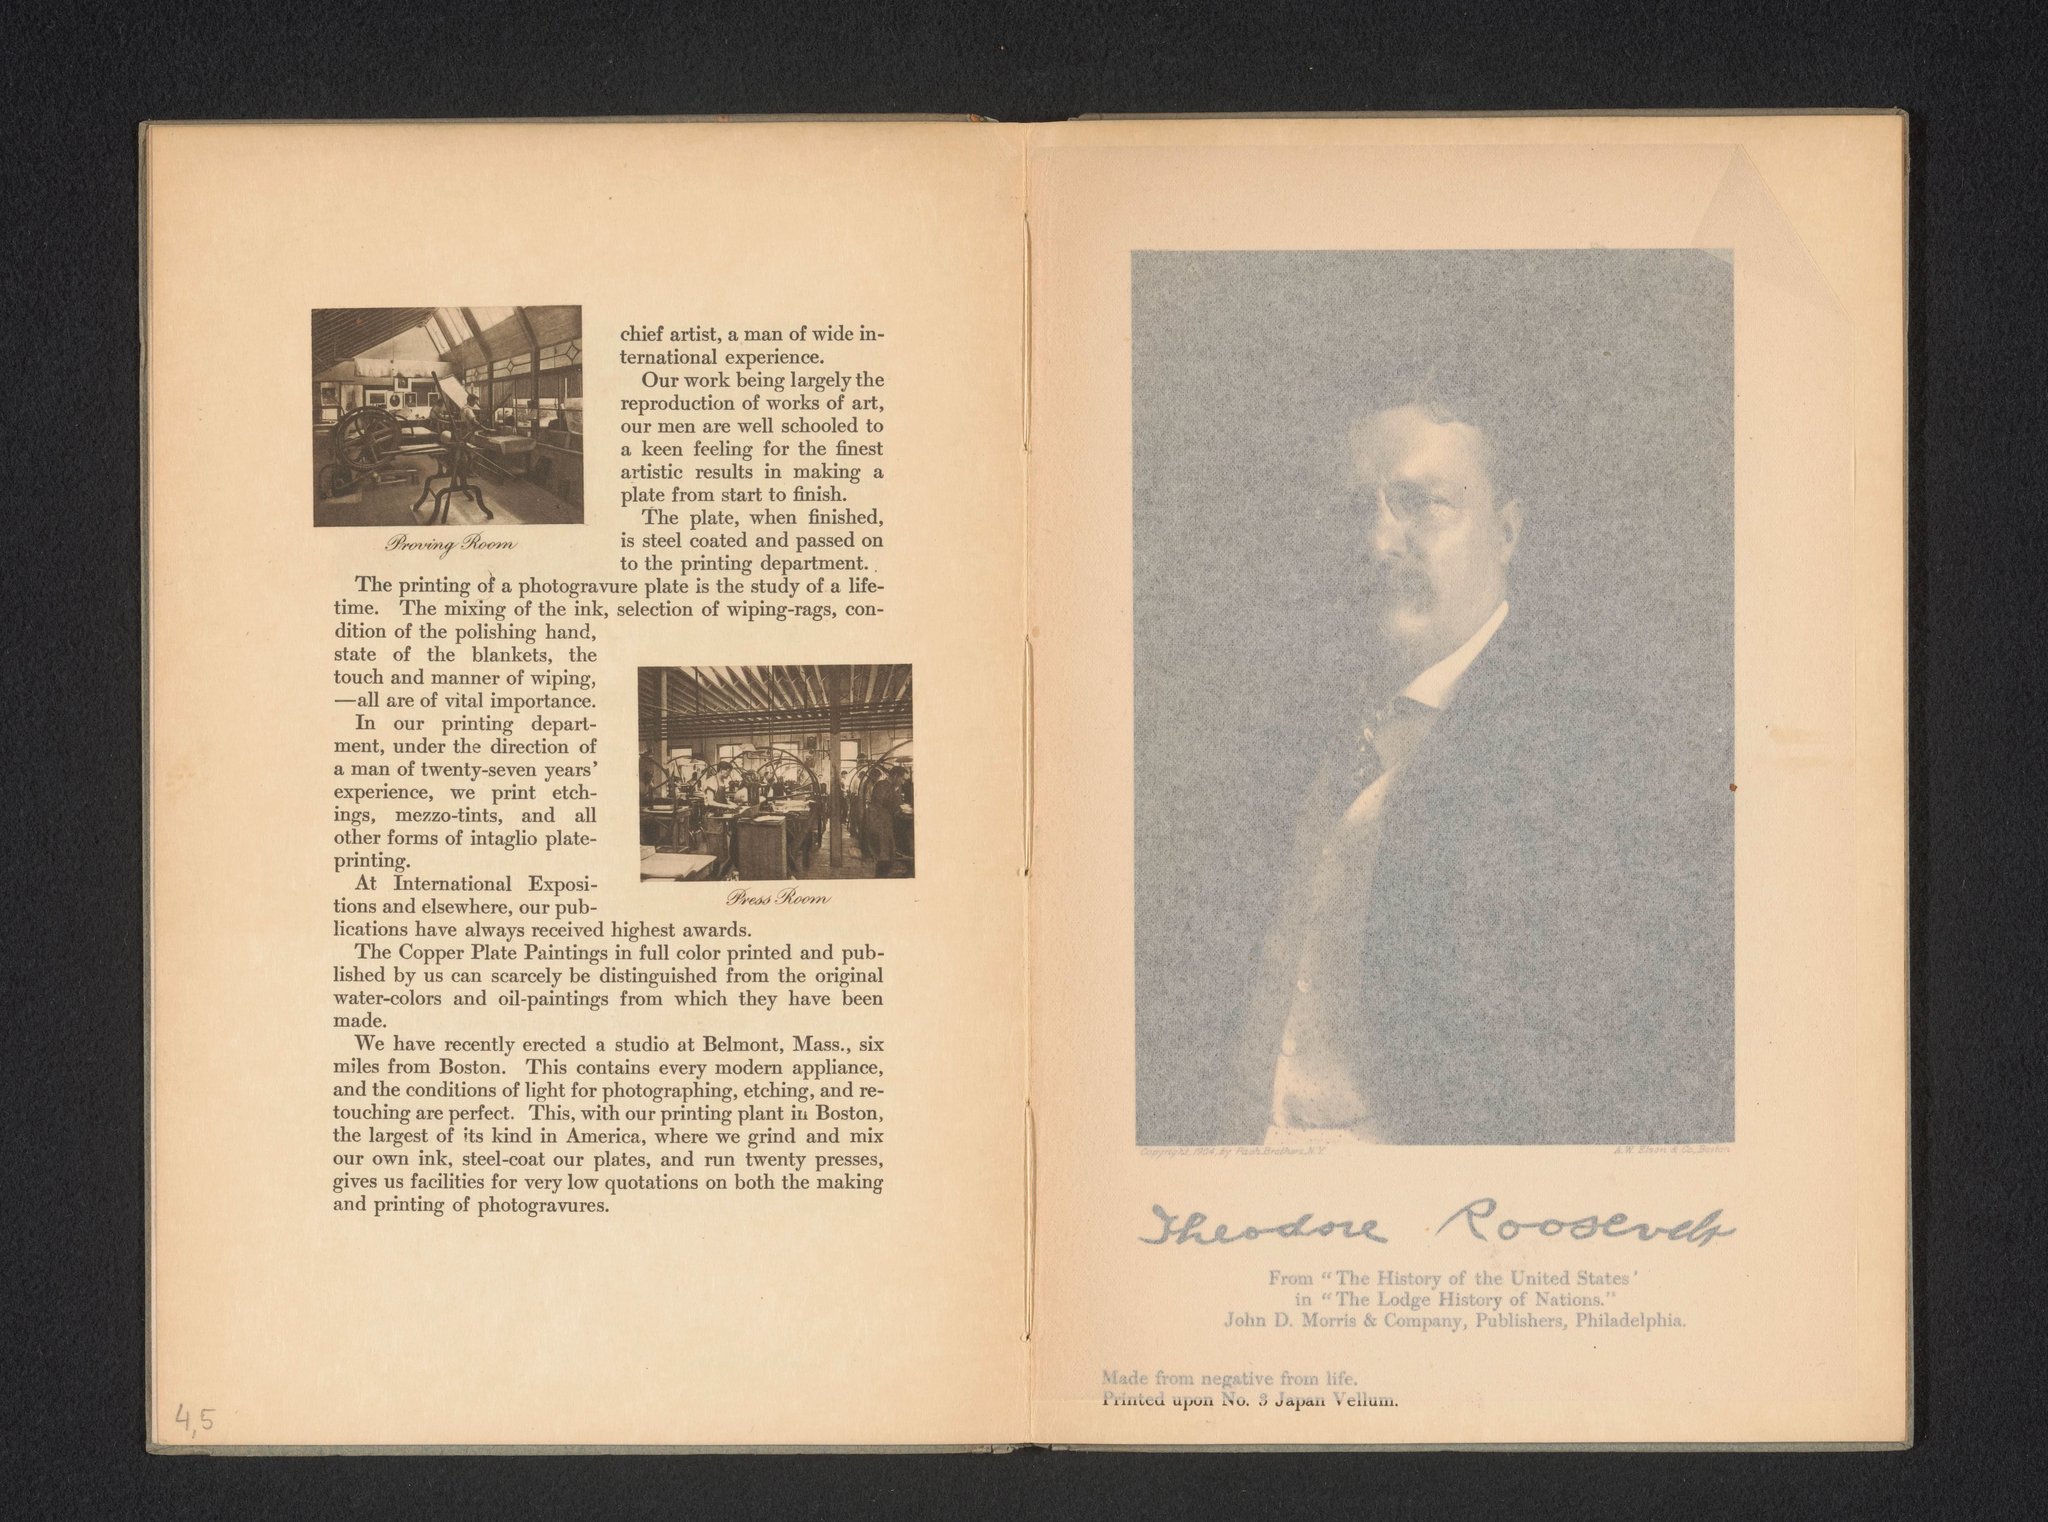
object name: photomechanical print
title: Kamer met proefdrukken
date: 1903-1908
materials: paper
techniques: photograph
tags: printing, printing office